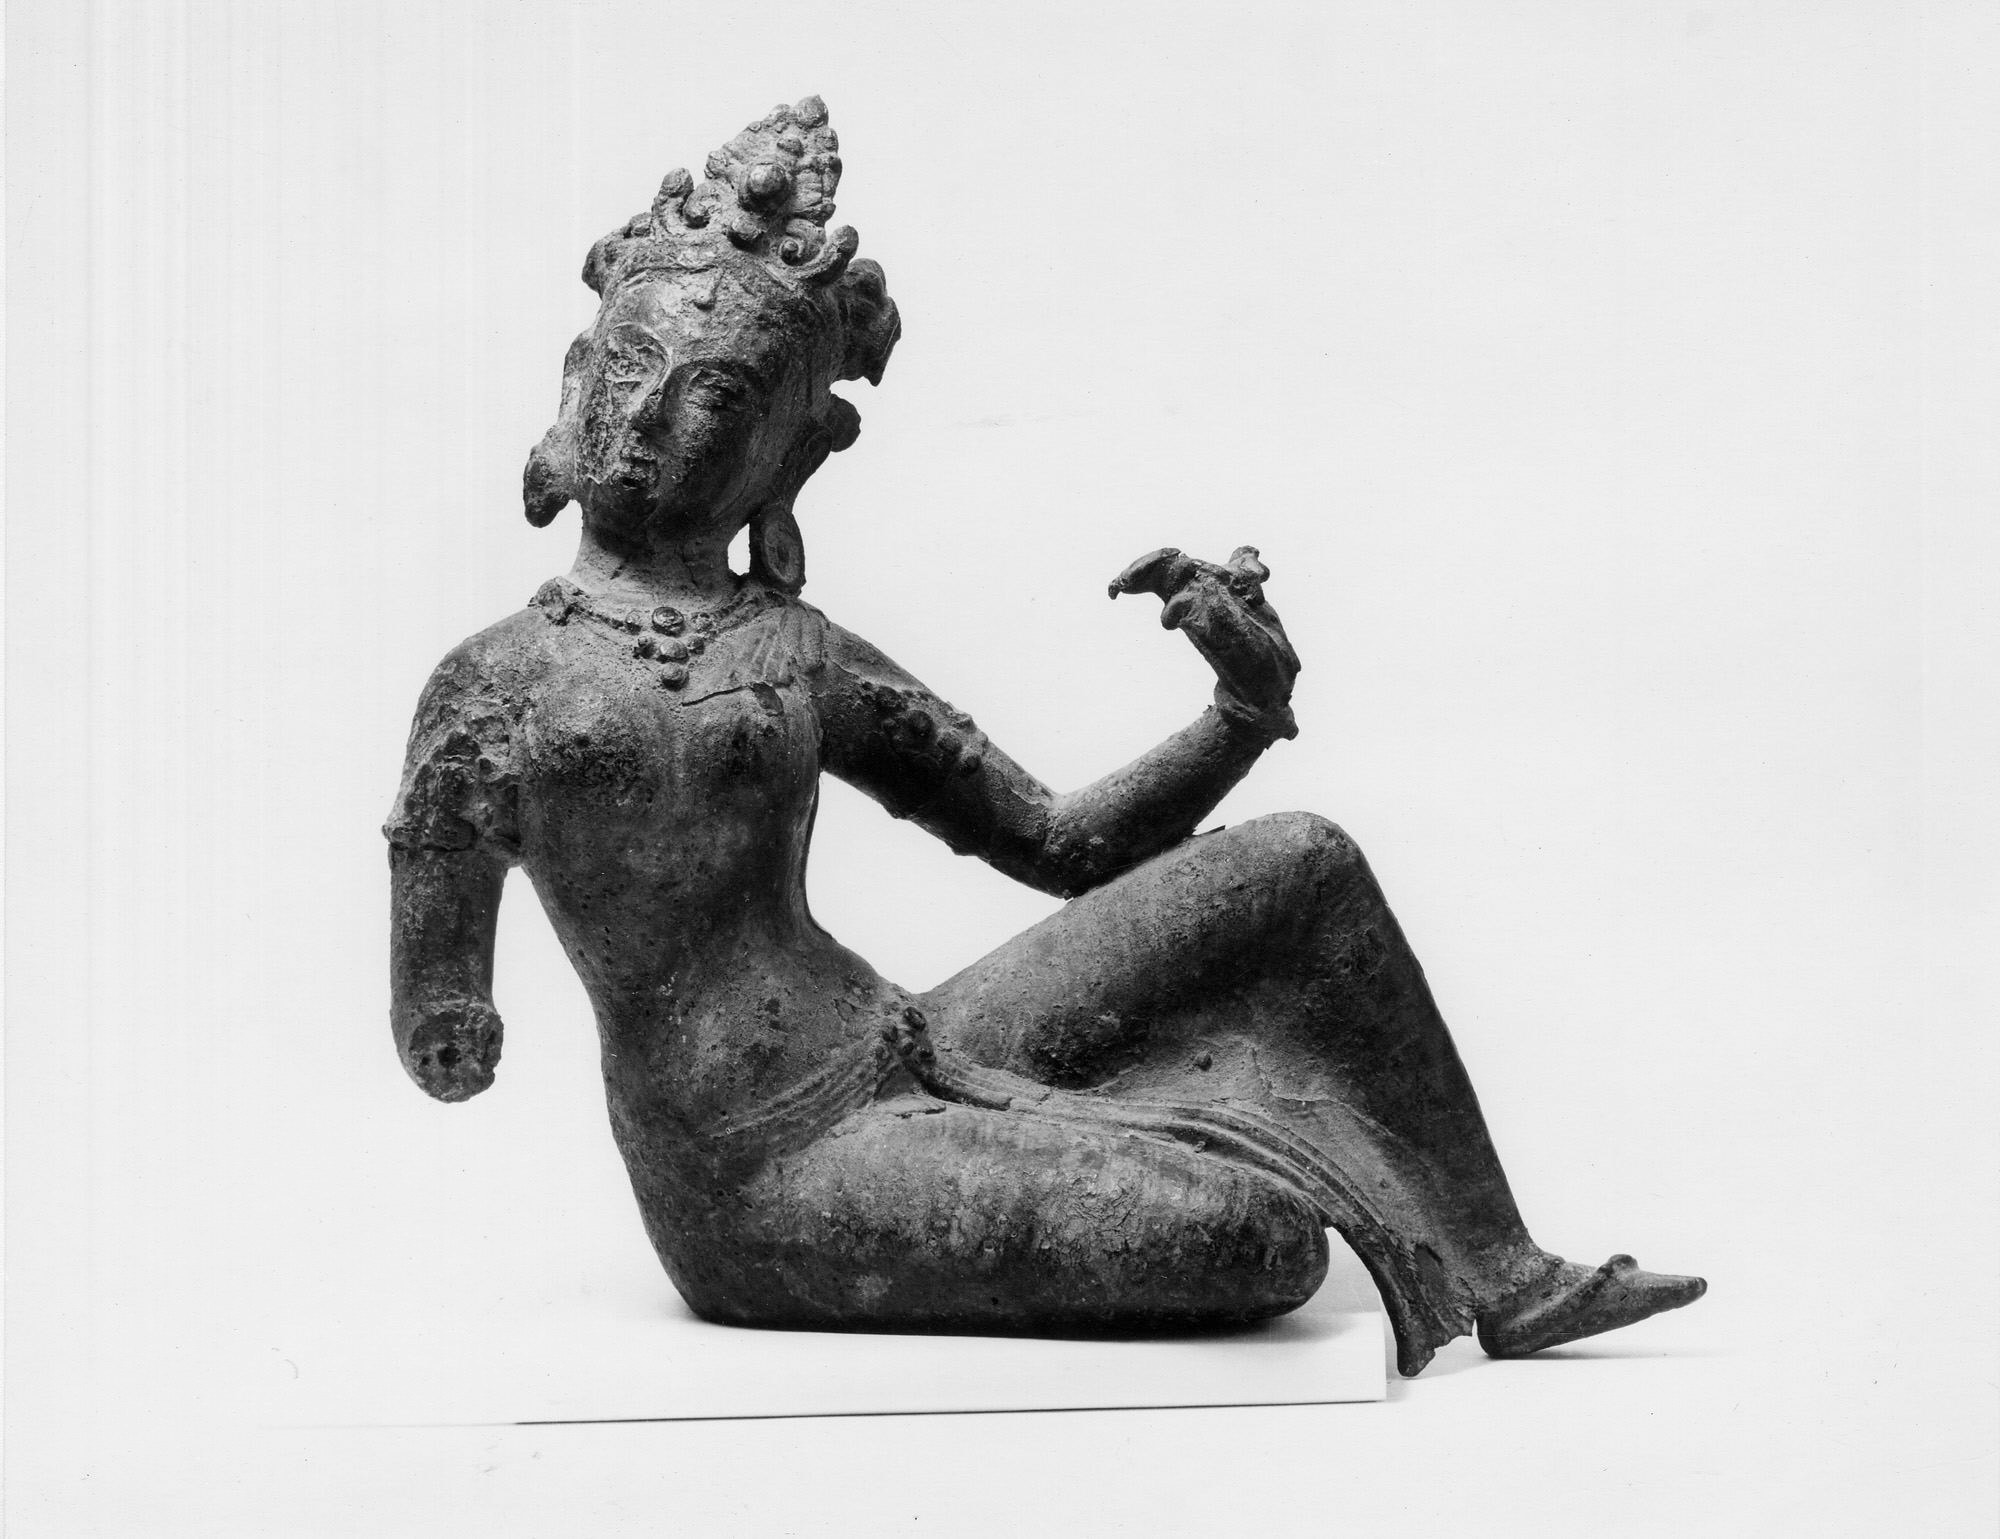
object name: figure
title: Seated Uma from a Group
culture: nepali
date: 1001-1100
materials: bronze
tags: goddess,hinduism